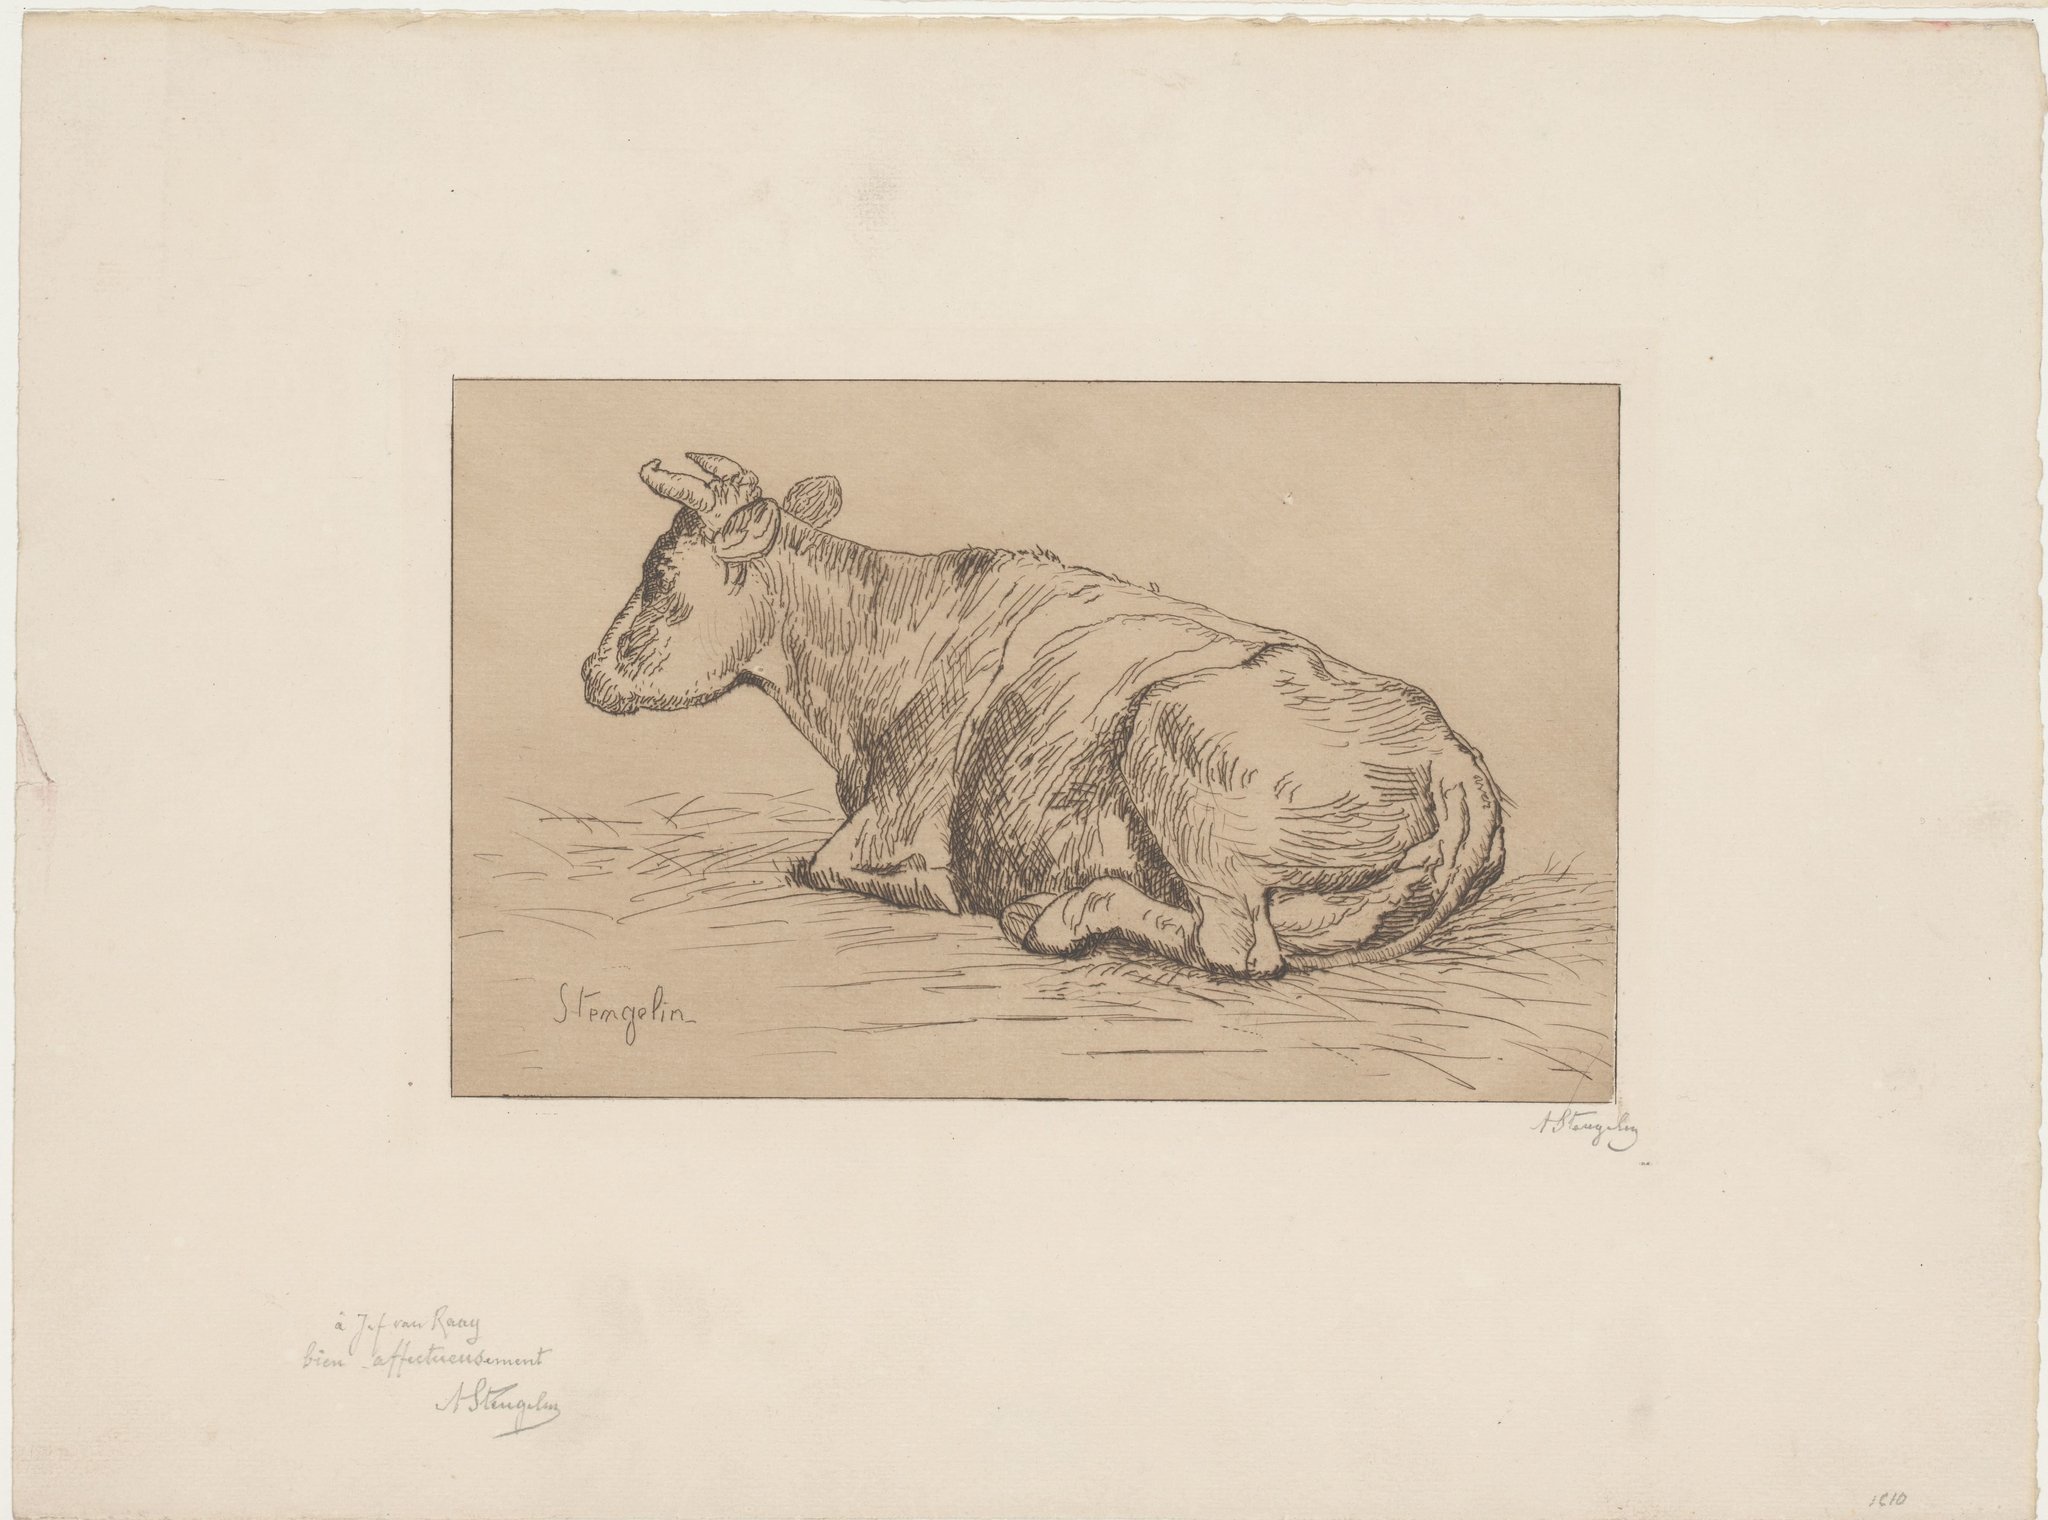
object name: print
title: Liggende koe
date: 1862-1938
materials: paper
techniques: etching, intaglio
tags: cow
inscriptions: collector's mark: Lugt 2228